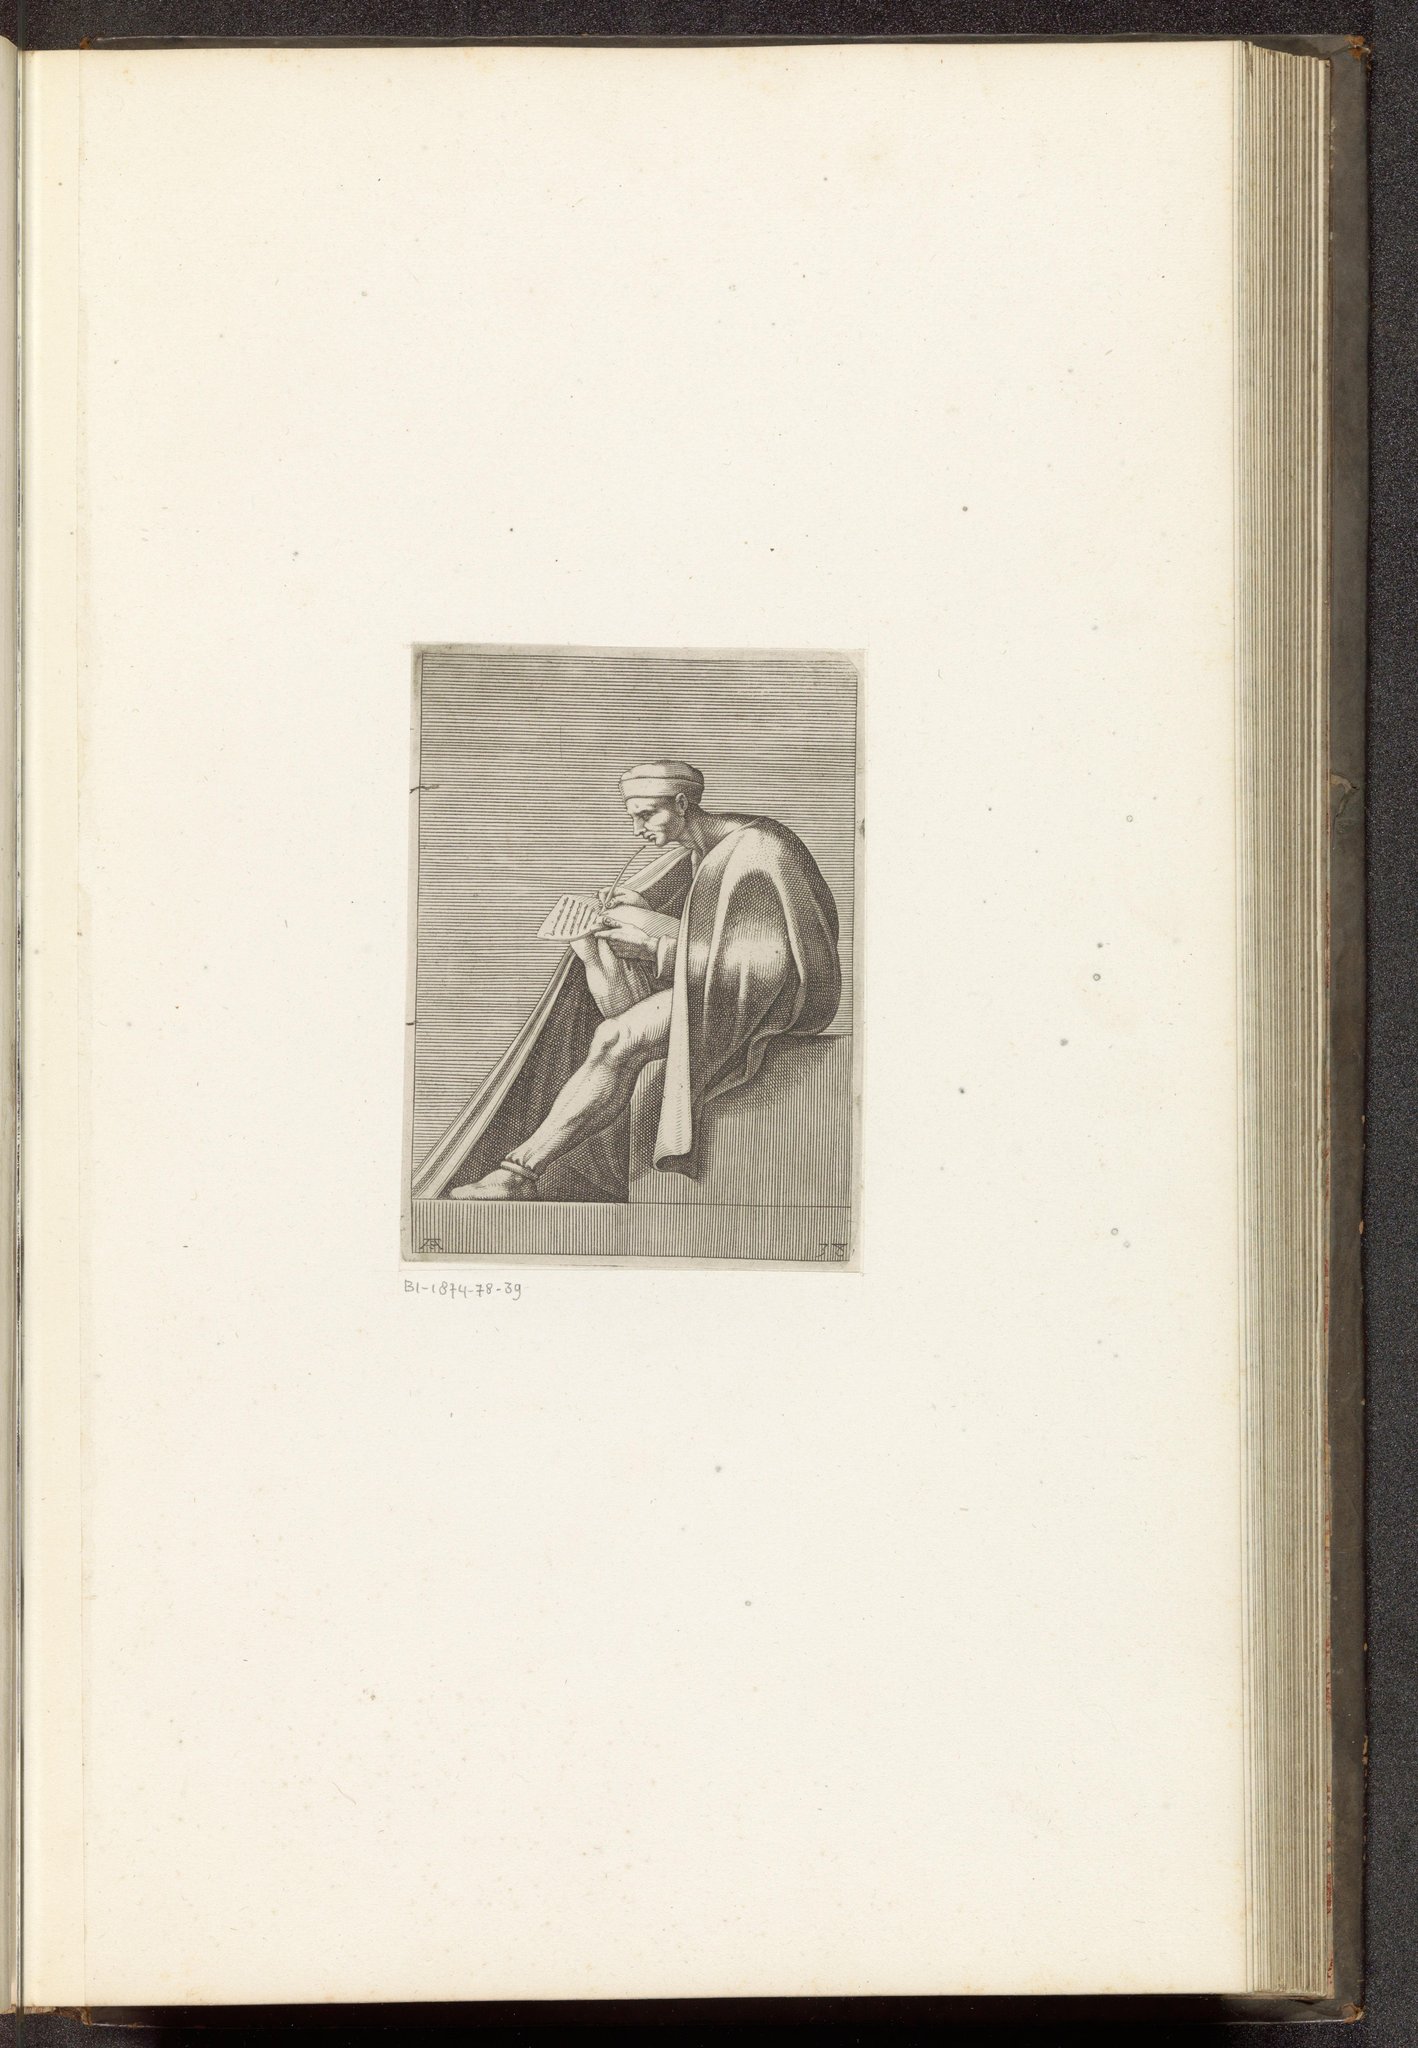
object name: album leaf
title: Schilderingen in de Sixtijnse kapel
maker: adamo scultori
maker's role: painter, print maker, sculptor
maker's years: 1530-1585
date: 1585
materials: paper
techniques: engraving, intaglio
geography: italy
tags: handwriting, written text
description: Deze prent maakt deel uit van een serie bestaande uit een titelprent en 72 prenten naar schilderingen door Michelangelo in de Sixtijnse Kapel in het Vaticaan.